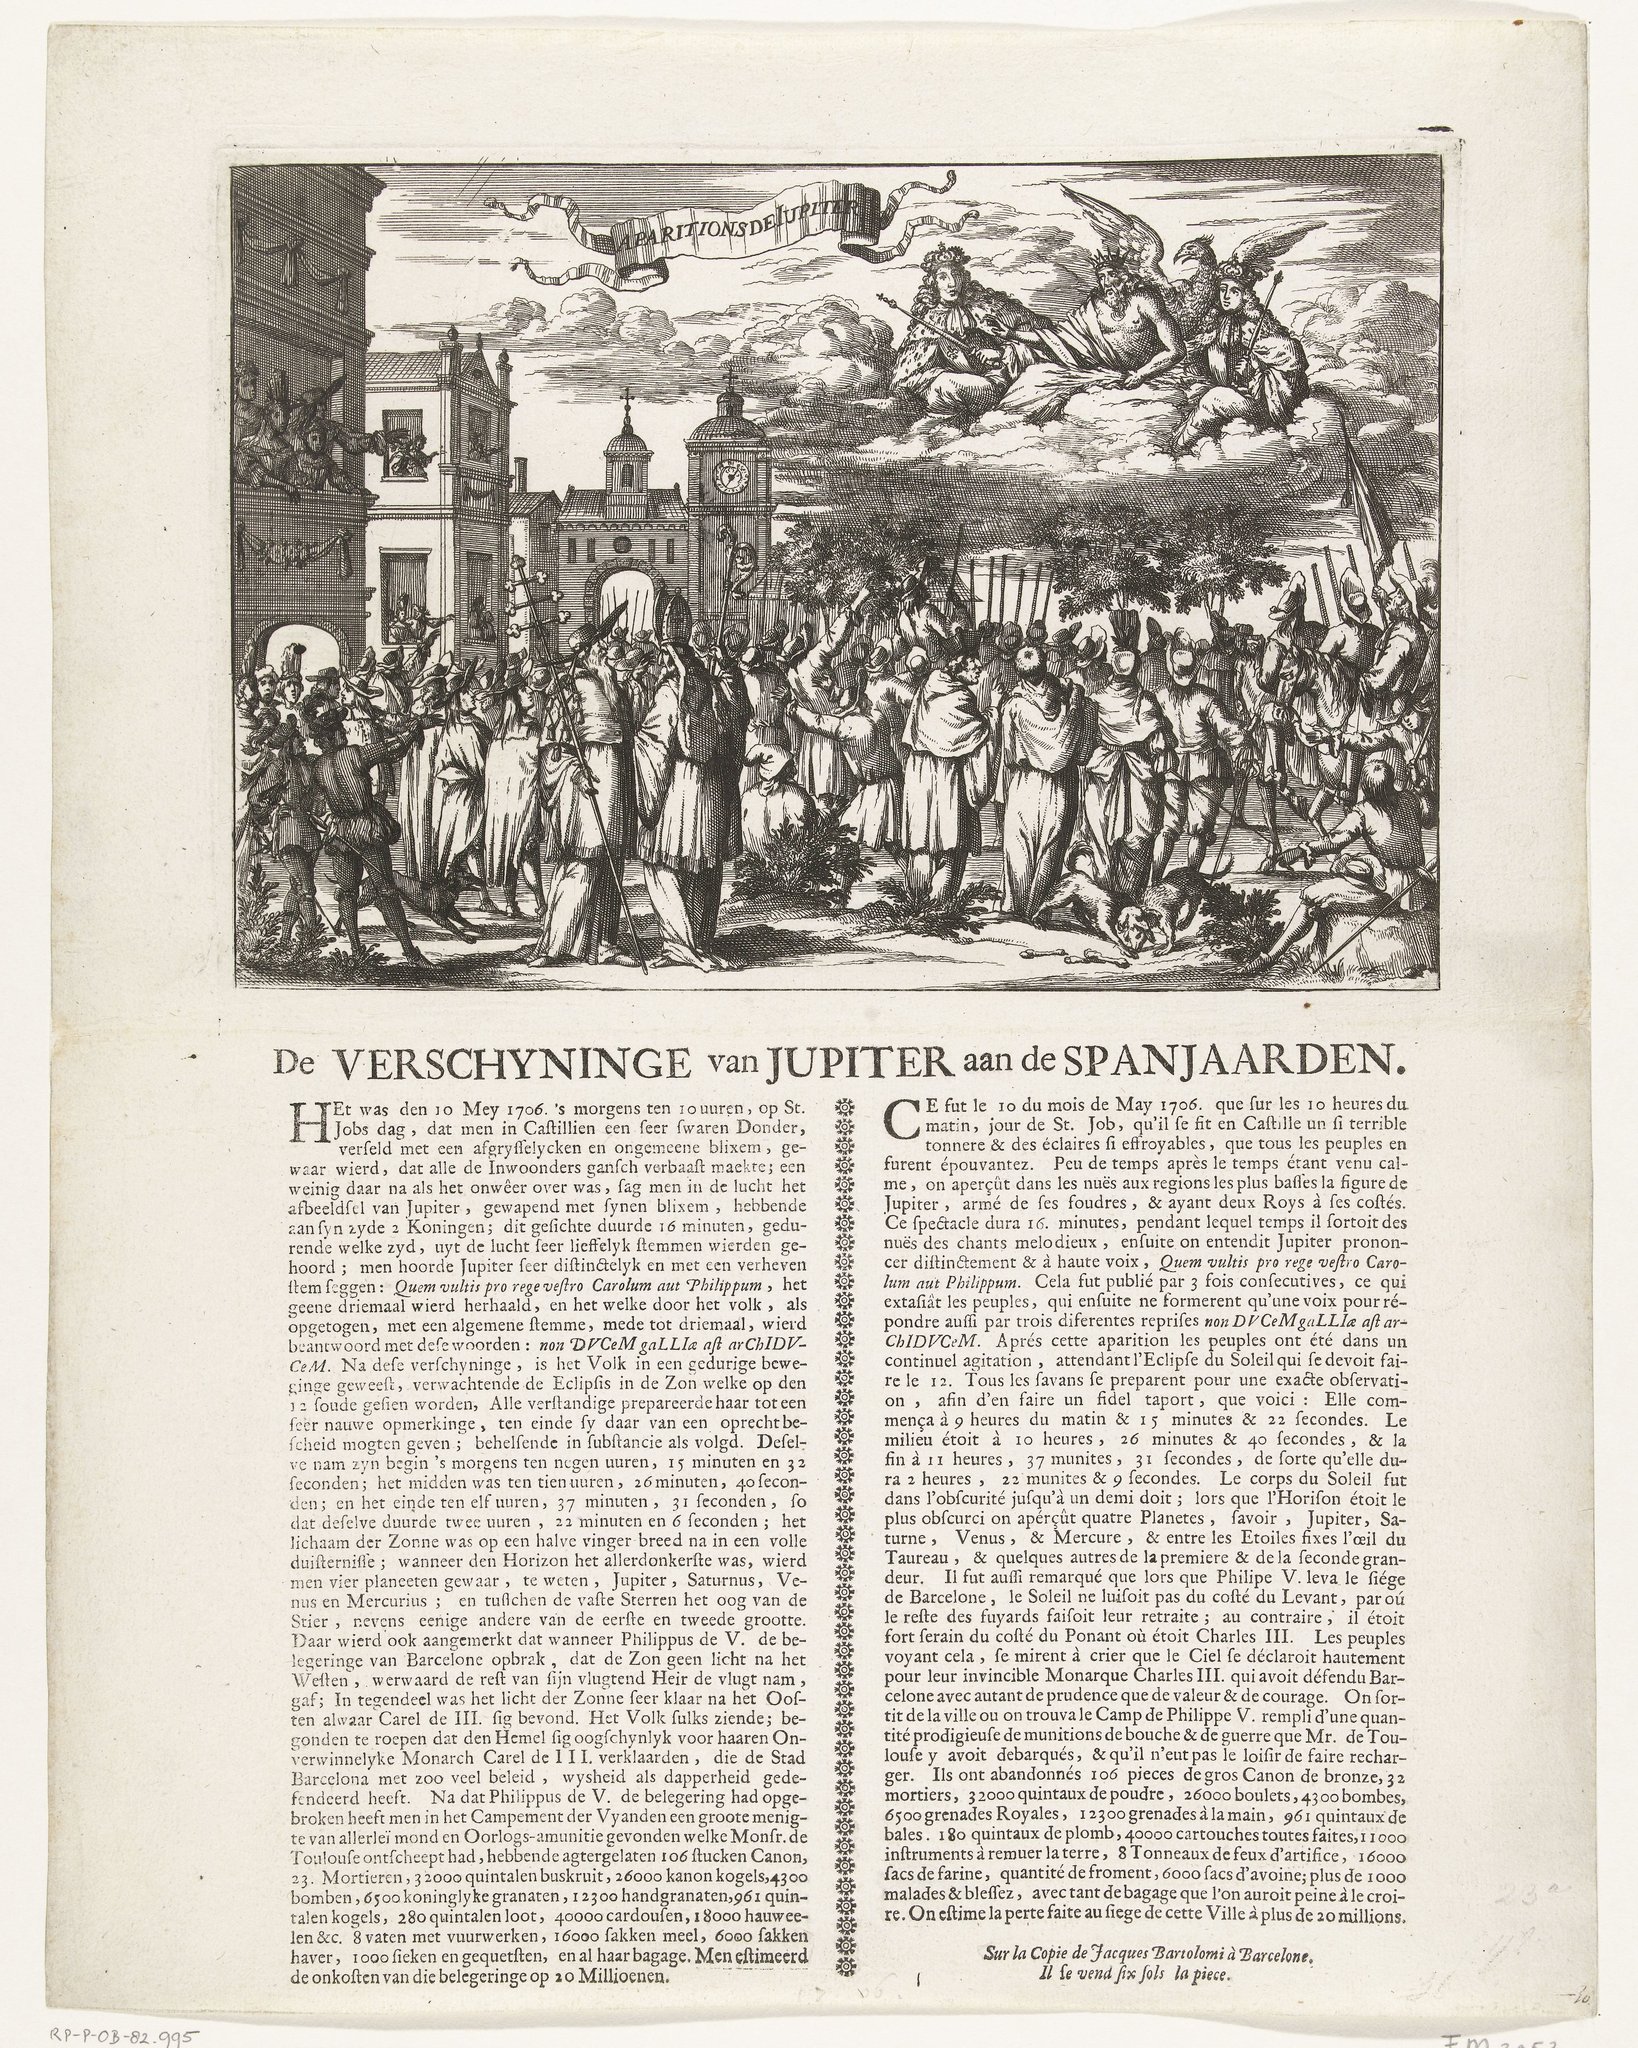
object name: print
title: Jupiter verschijnt met twee koningen aan de Spanjaarden, 1706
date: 1706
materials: paper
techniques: etching, letterpress printing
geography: amsterdam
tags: filips v (koning van spanje), vienna, charles vi (holy roman emperor), specific aspects, allegorical aspects of jupiter; jupiter as patron, political caricatures and satires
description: Jupiter verschijnt aan de hemel samen met aartshertog Karel van Oostenrijk en Filips V aan een publiek te Madrid, 10 mei 1706. De god vraagt de aanwezigen welke vorst zij als koning willen. Op het blad onder de plaat een beschrijving van de gebeurtenissen in het Nederlands en Frans. Onderdeel van een reeks van 19 spotprenten op de Fransen en bondgenoten uit het jaar 1706.